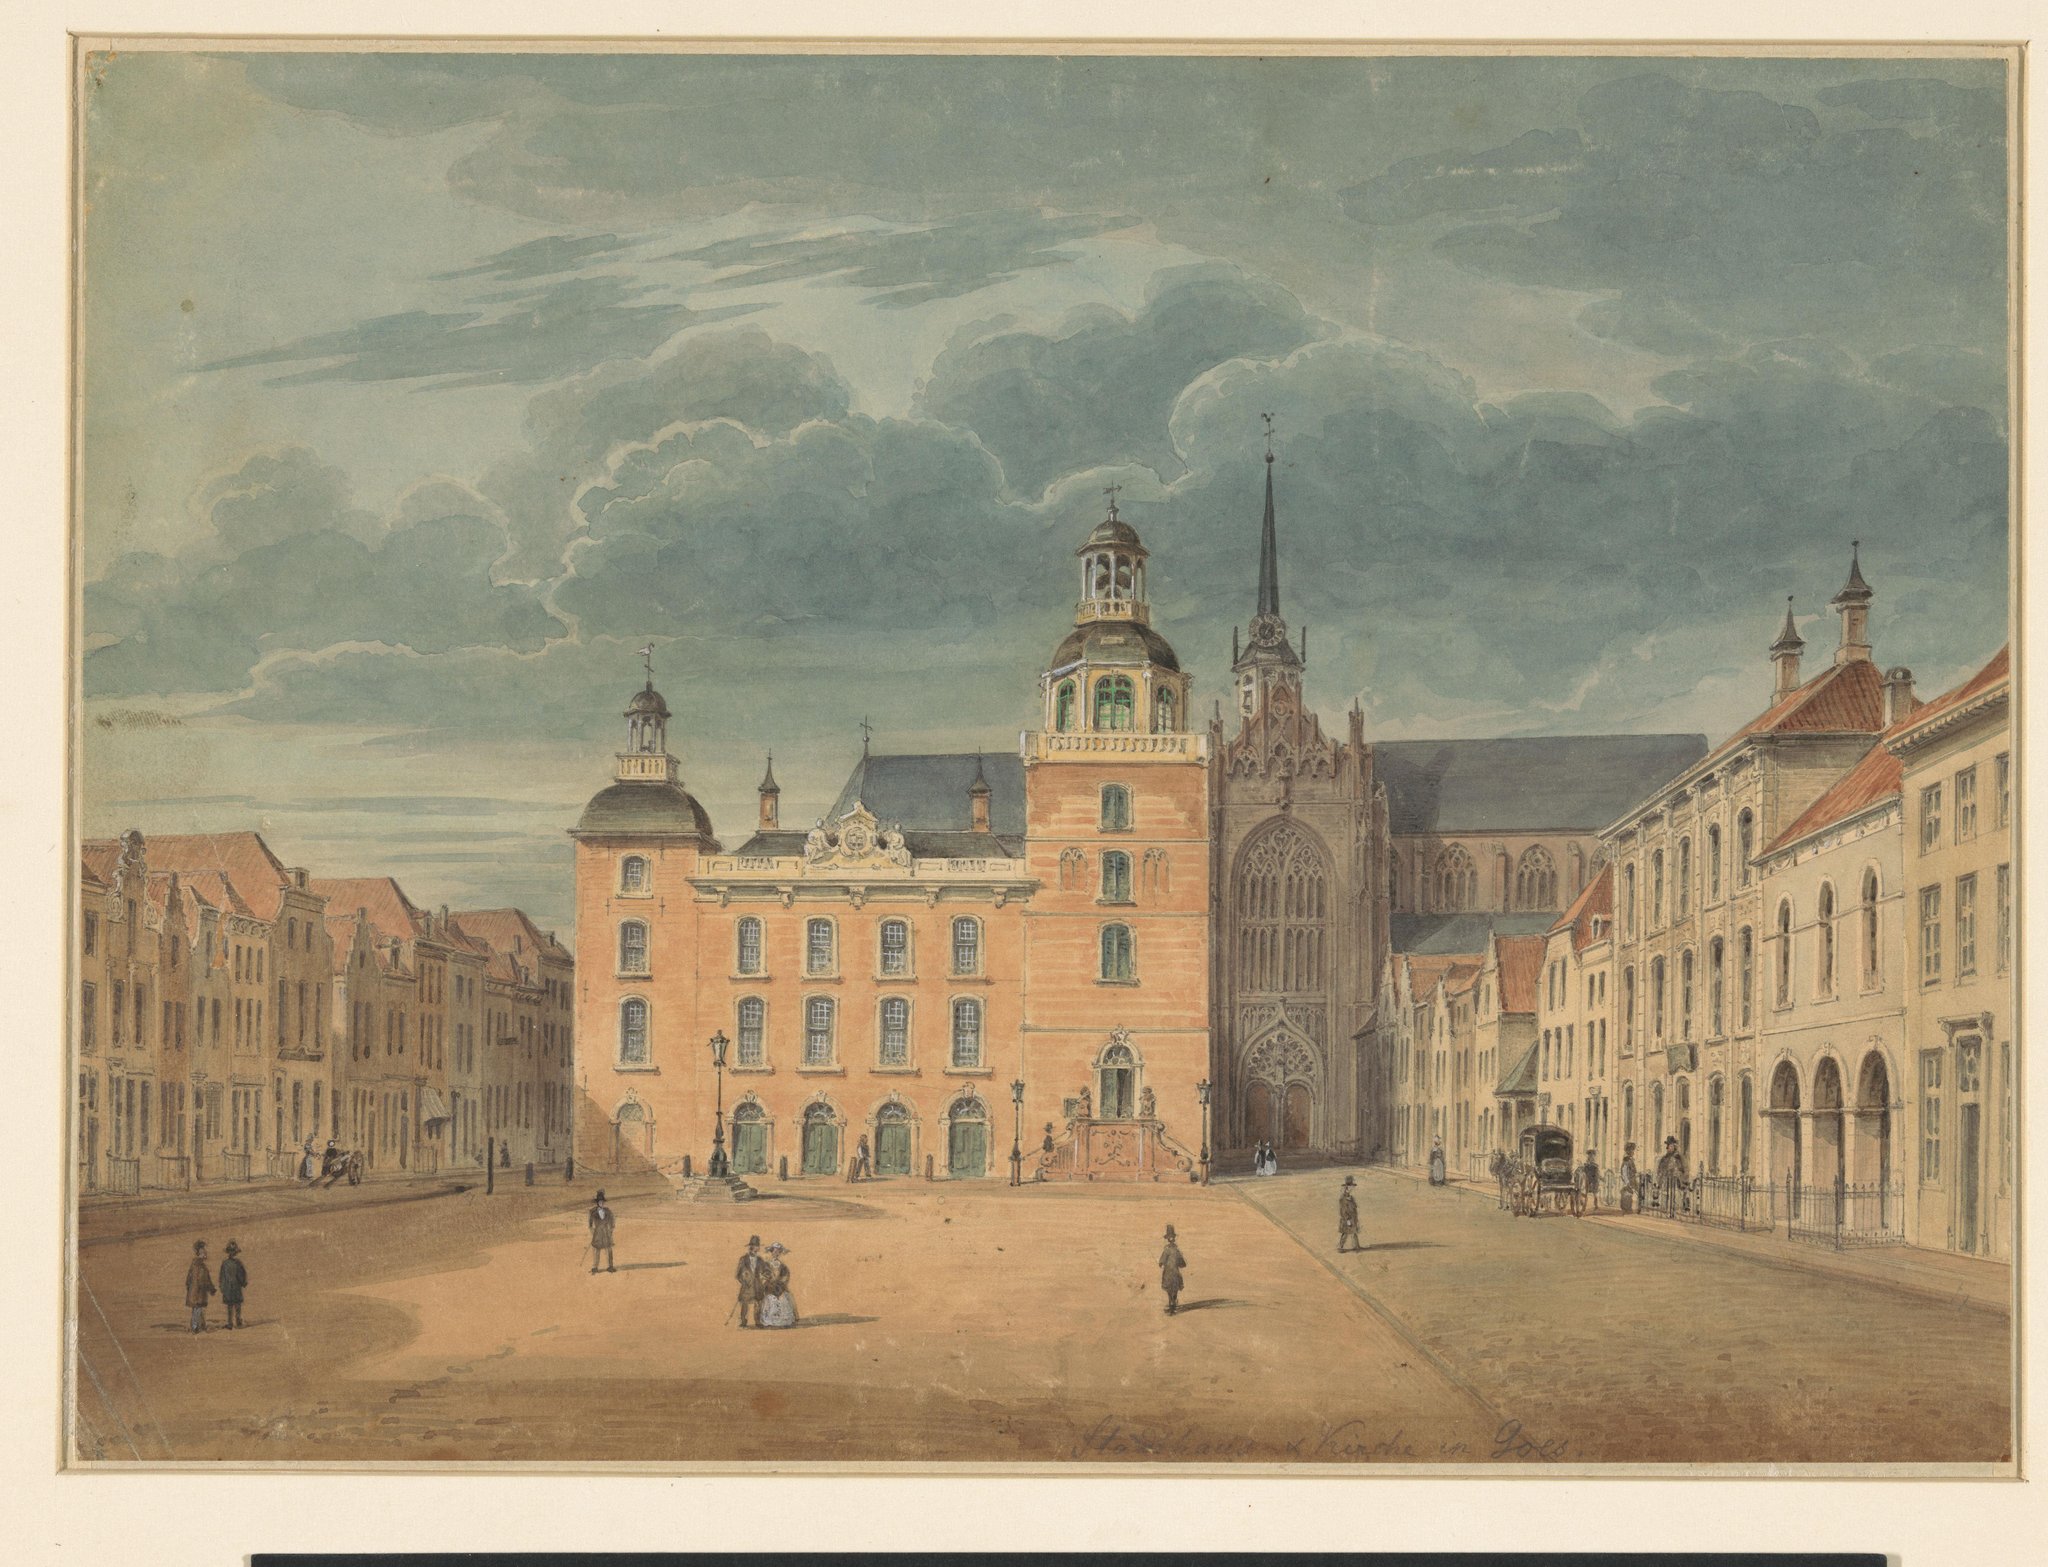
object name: drawing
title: Stadhuis en kerk te Goes (Zeeland)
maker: théophile schuler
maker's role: draughtsman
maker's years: 1821-1878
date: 1838-1878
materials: paper, pencil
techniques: brush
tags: church (exterior), townhall, square, place, circus, etc. (+ city(-scape) with figures, staffage)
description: Stadhuis en Grote of Maria Magdalenakerk aan de Grote Markt te Goes.